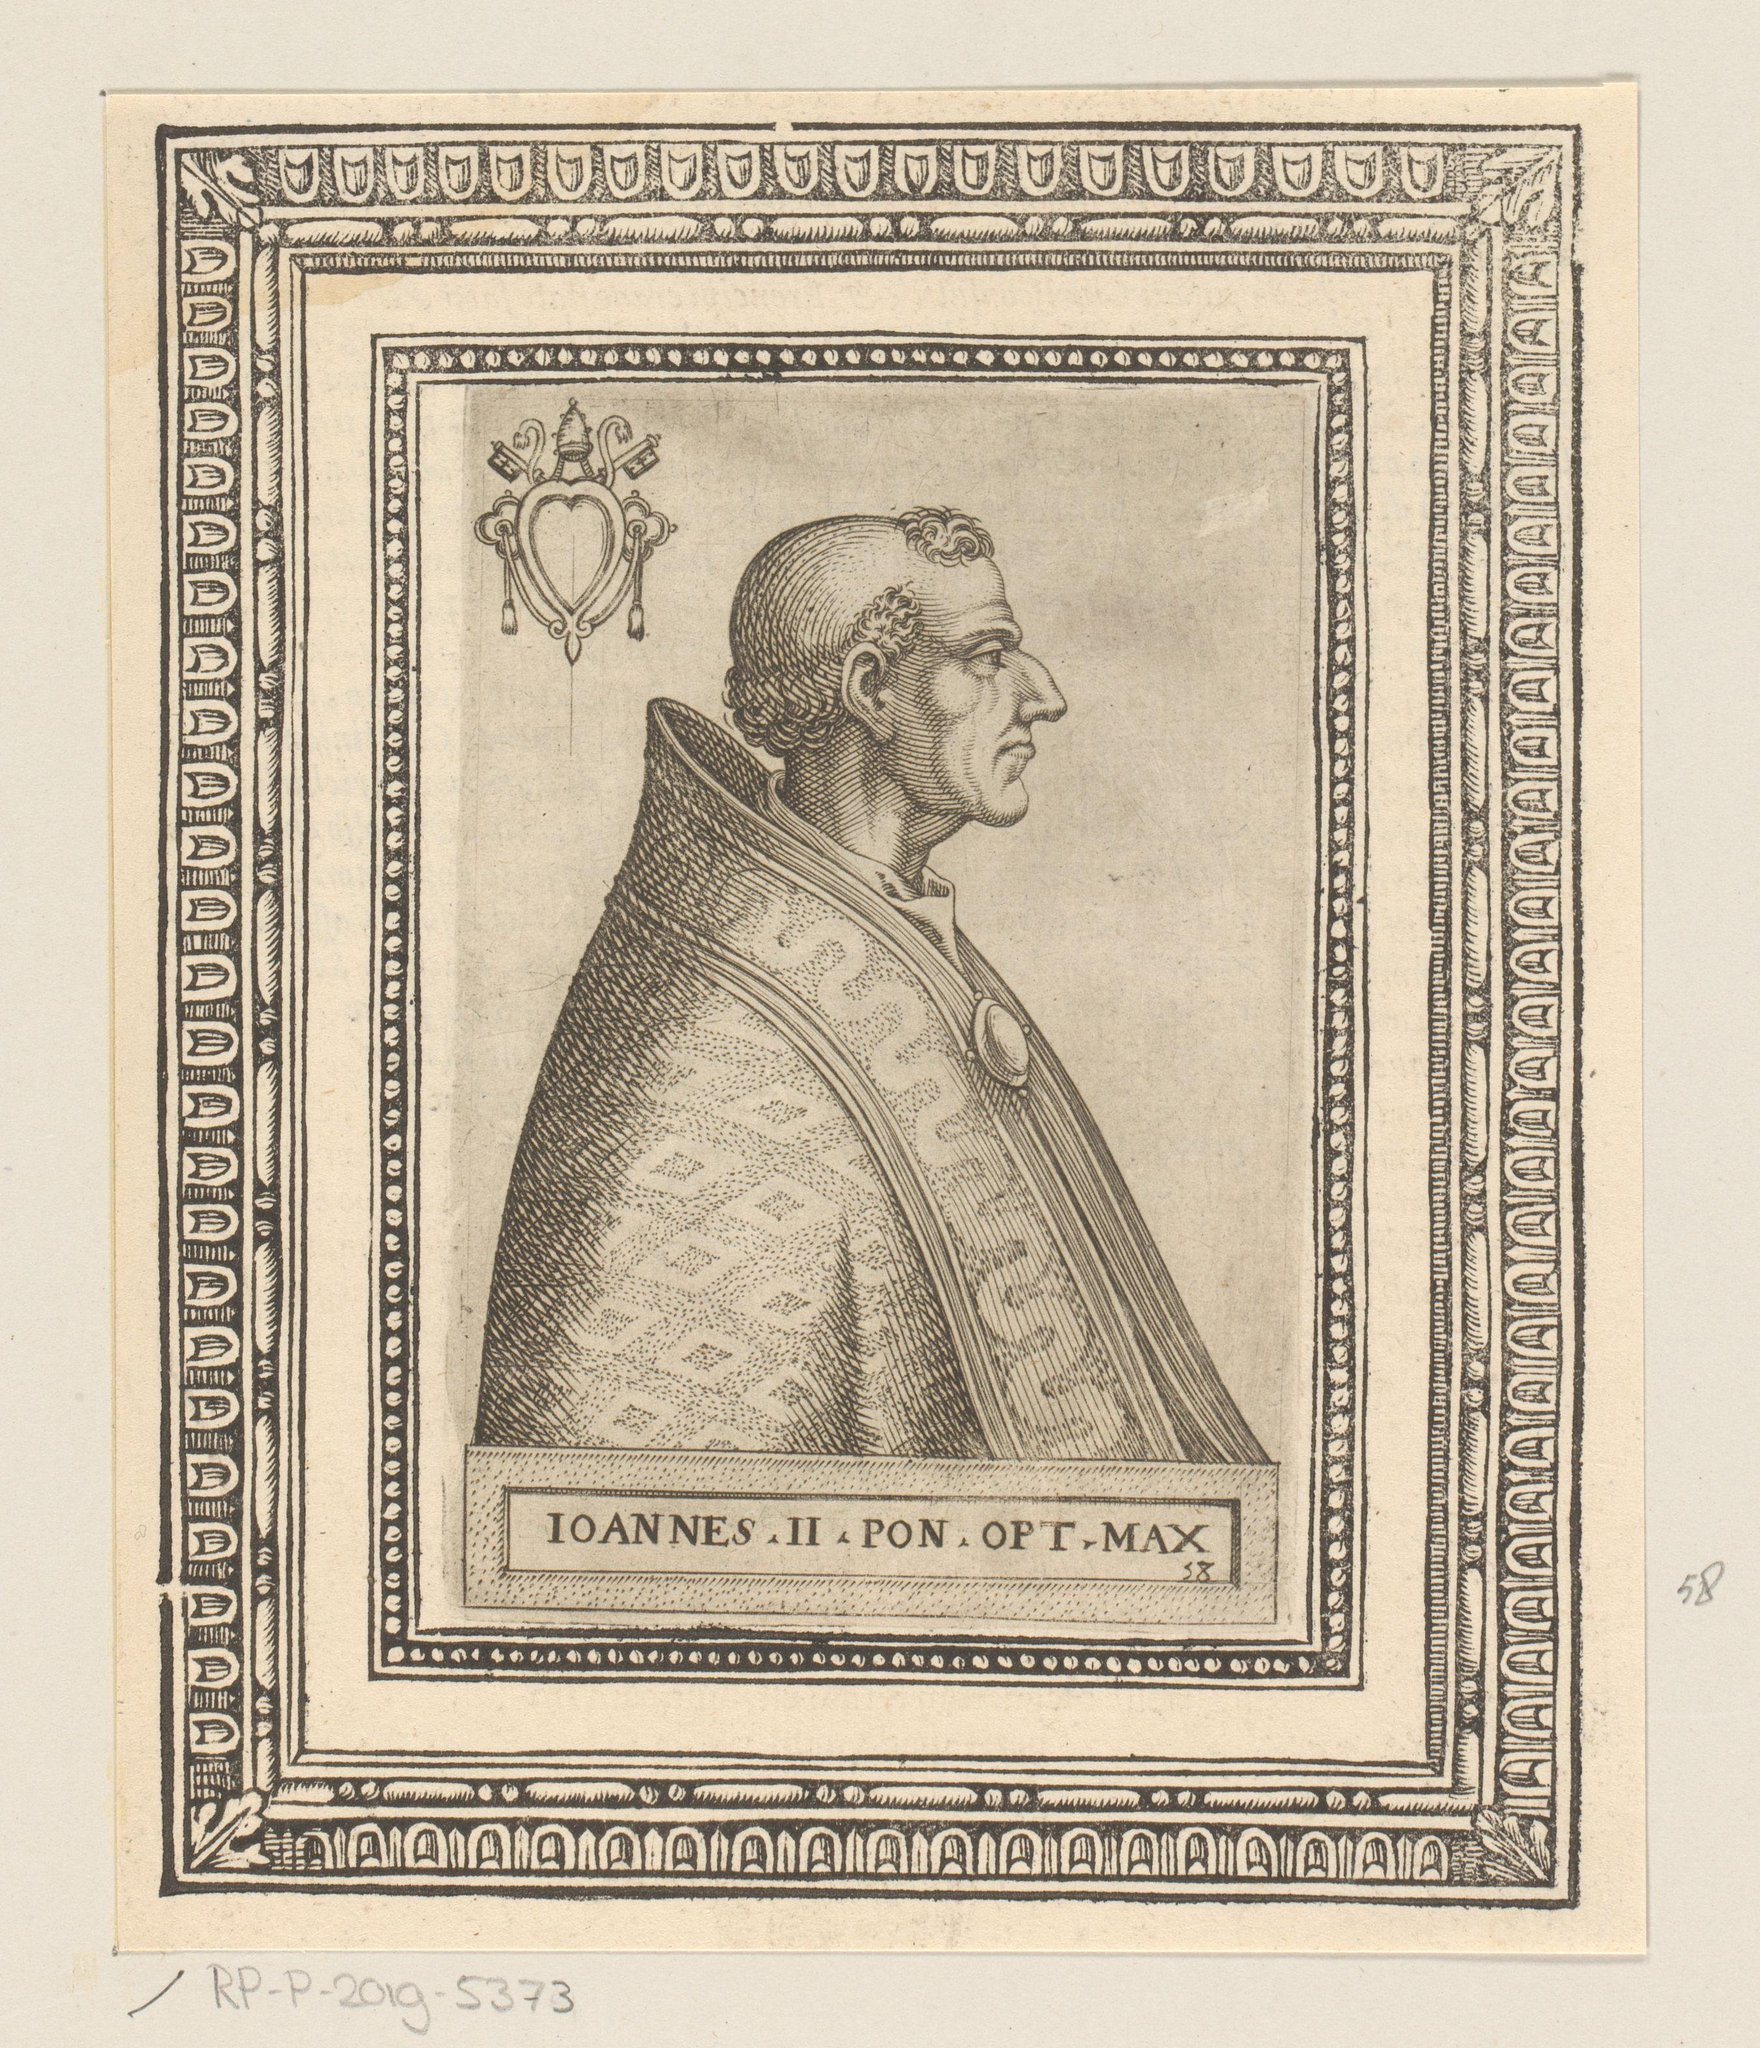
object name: book illustration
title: Portret van paus Johannes II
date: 1587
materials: paper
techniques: engraving, letterpress printing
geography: rome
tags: historical persons, pope, armorial bearing, heraldry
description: Prent uit: Ciccarelli, Antonio. Le vite de Pontefici di Antonio Ciccarelli (...). Rome: Domenico Basa, 1587. Prent voor het eerst verschenen in: Cavalieri, Giovanni Battista de'. Pontificum romanorum effigies (...). Rome: Domenico Basa en Francesco Zanetti, 1580. Prent ook gebruikt in latere publicaties.